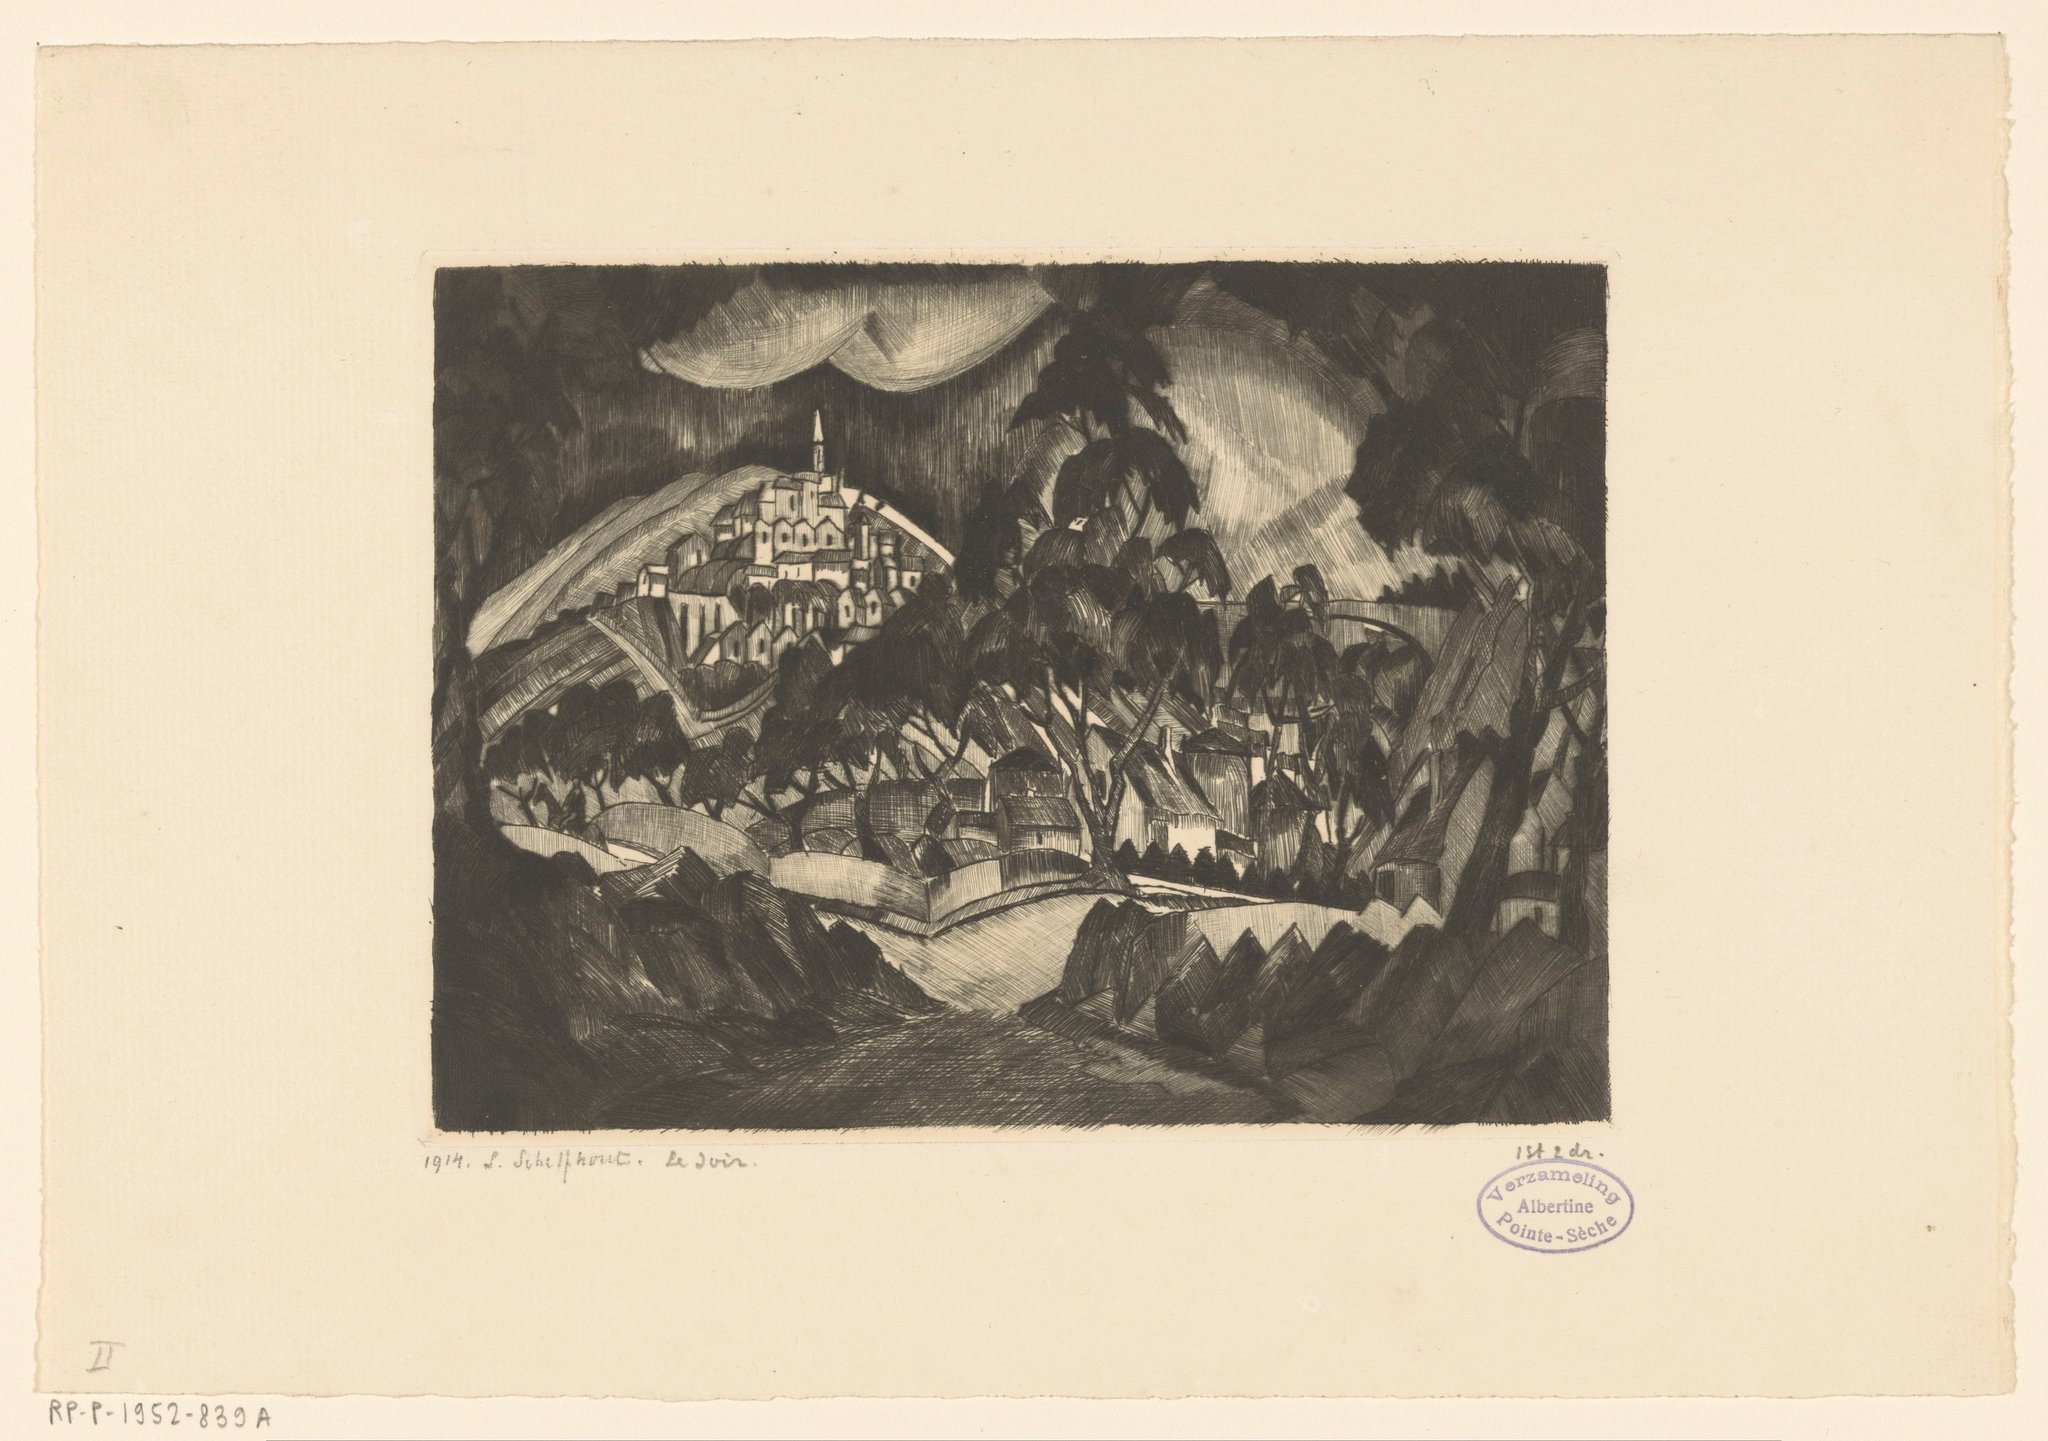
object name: print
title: Heuvellandschap met bomen en bebouwing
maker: lodewijk schelfhout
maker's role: draughtsman, print maker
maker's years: 1881-1943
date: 1914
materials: paper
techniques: drypoint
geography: netherlands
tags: prospect of village, silhouette of village, low hill country, evening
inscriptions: collector's mark: Lugt 2760, collector's mark: Lugt 2228, collector's mark: Lugt 5i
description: Op de achtergrond een nederzetting met kerk op een heuvel.